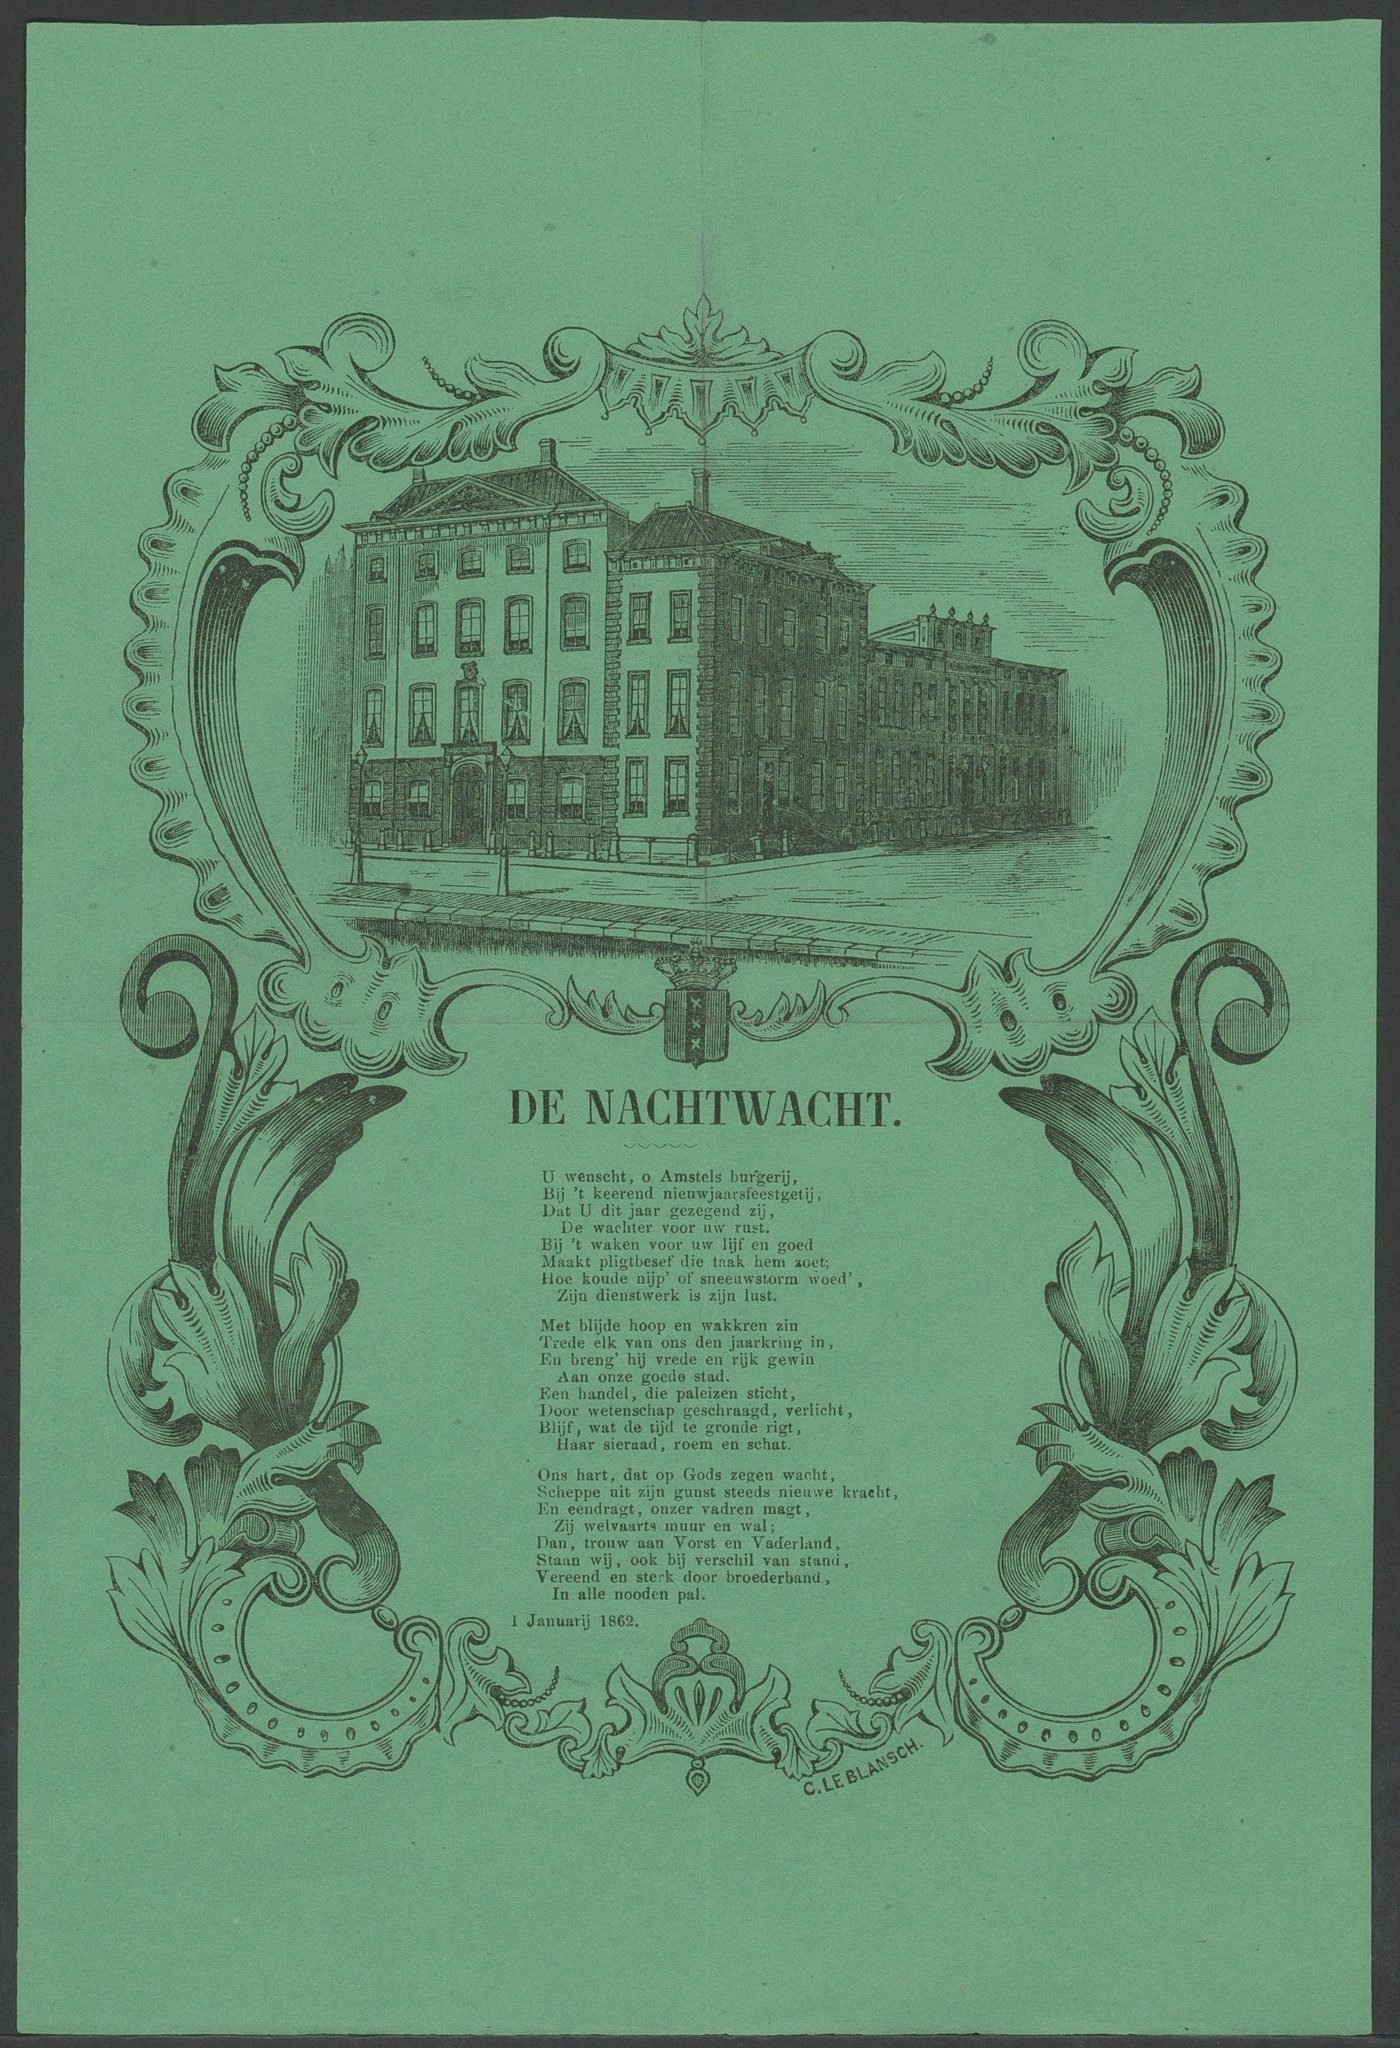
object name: new year card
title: Nieuwjaarswens van de Amsterdamse nachtwacht voor het jaar 1862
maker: christiaan le blansch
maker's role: print maker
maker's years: 1827-1886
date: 1861-1862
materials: paper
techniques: letterpress printing, engraving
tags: night patrol, pleasure fair and circus, amsterdam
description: Nieuwjaarswens van de Amsterdamse nachtwacht (ratelwacht) voor het jaar 1862. Centraal een gedicht in vier verzen, hieromheen randwerk en gezichten op twee gebouwen aan de gracht. Onderwerpsrubrieken binnen de Atlas Zeden en Gewoonten: Zeden en gewoonten in engeren zin, Volksleven, Volksbladen, Nieuwjaars- en Kerstwenschen, Amsterdam.